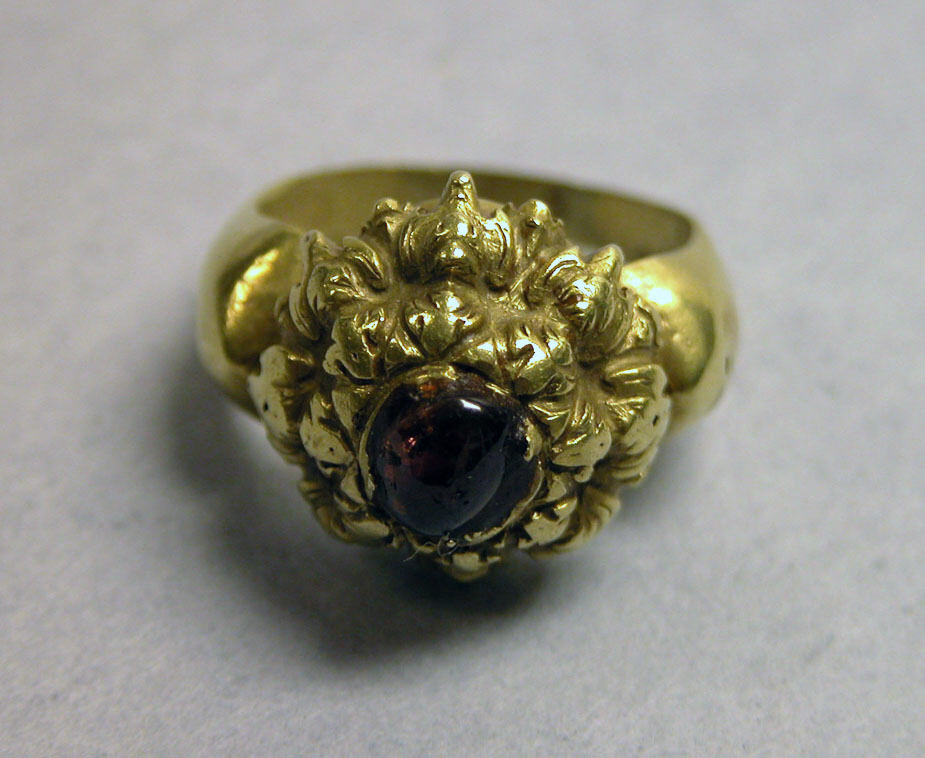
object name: ring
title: Stirrup-shaped Ring with Purple Circular Stone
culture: indonesian, javanese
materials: gold, stone